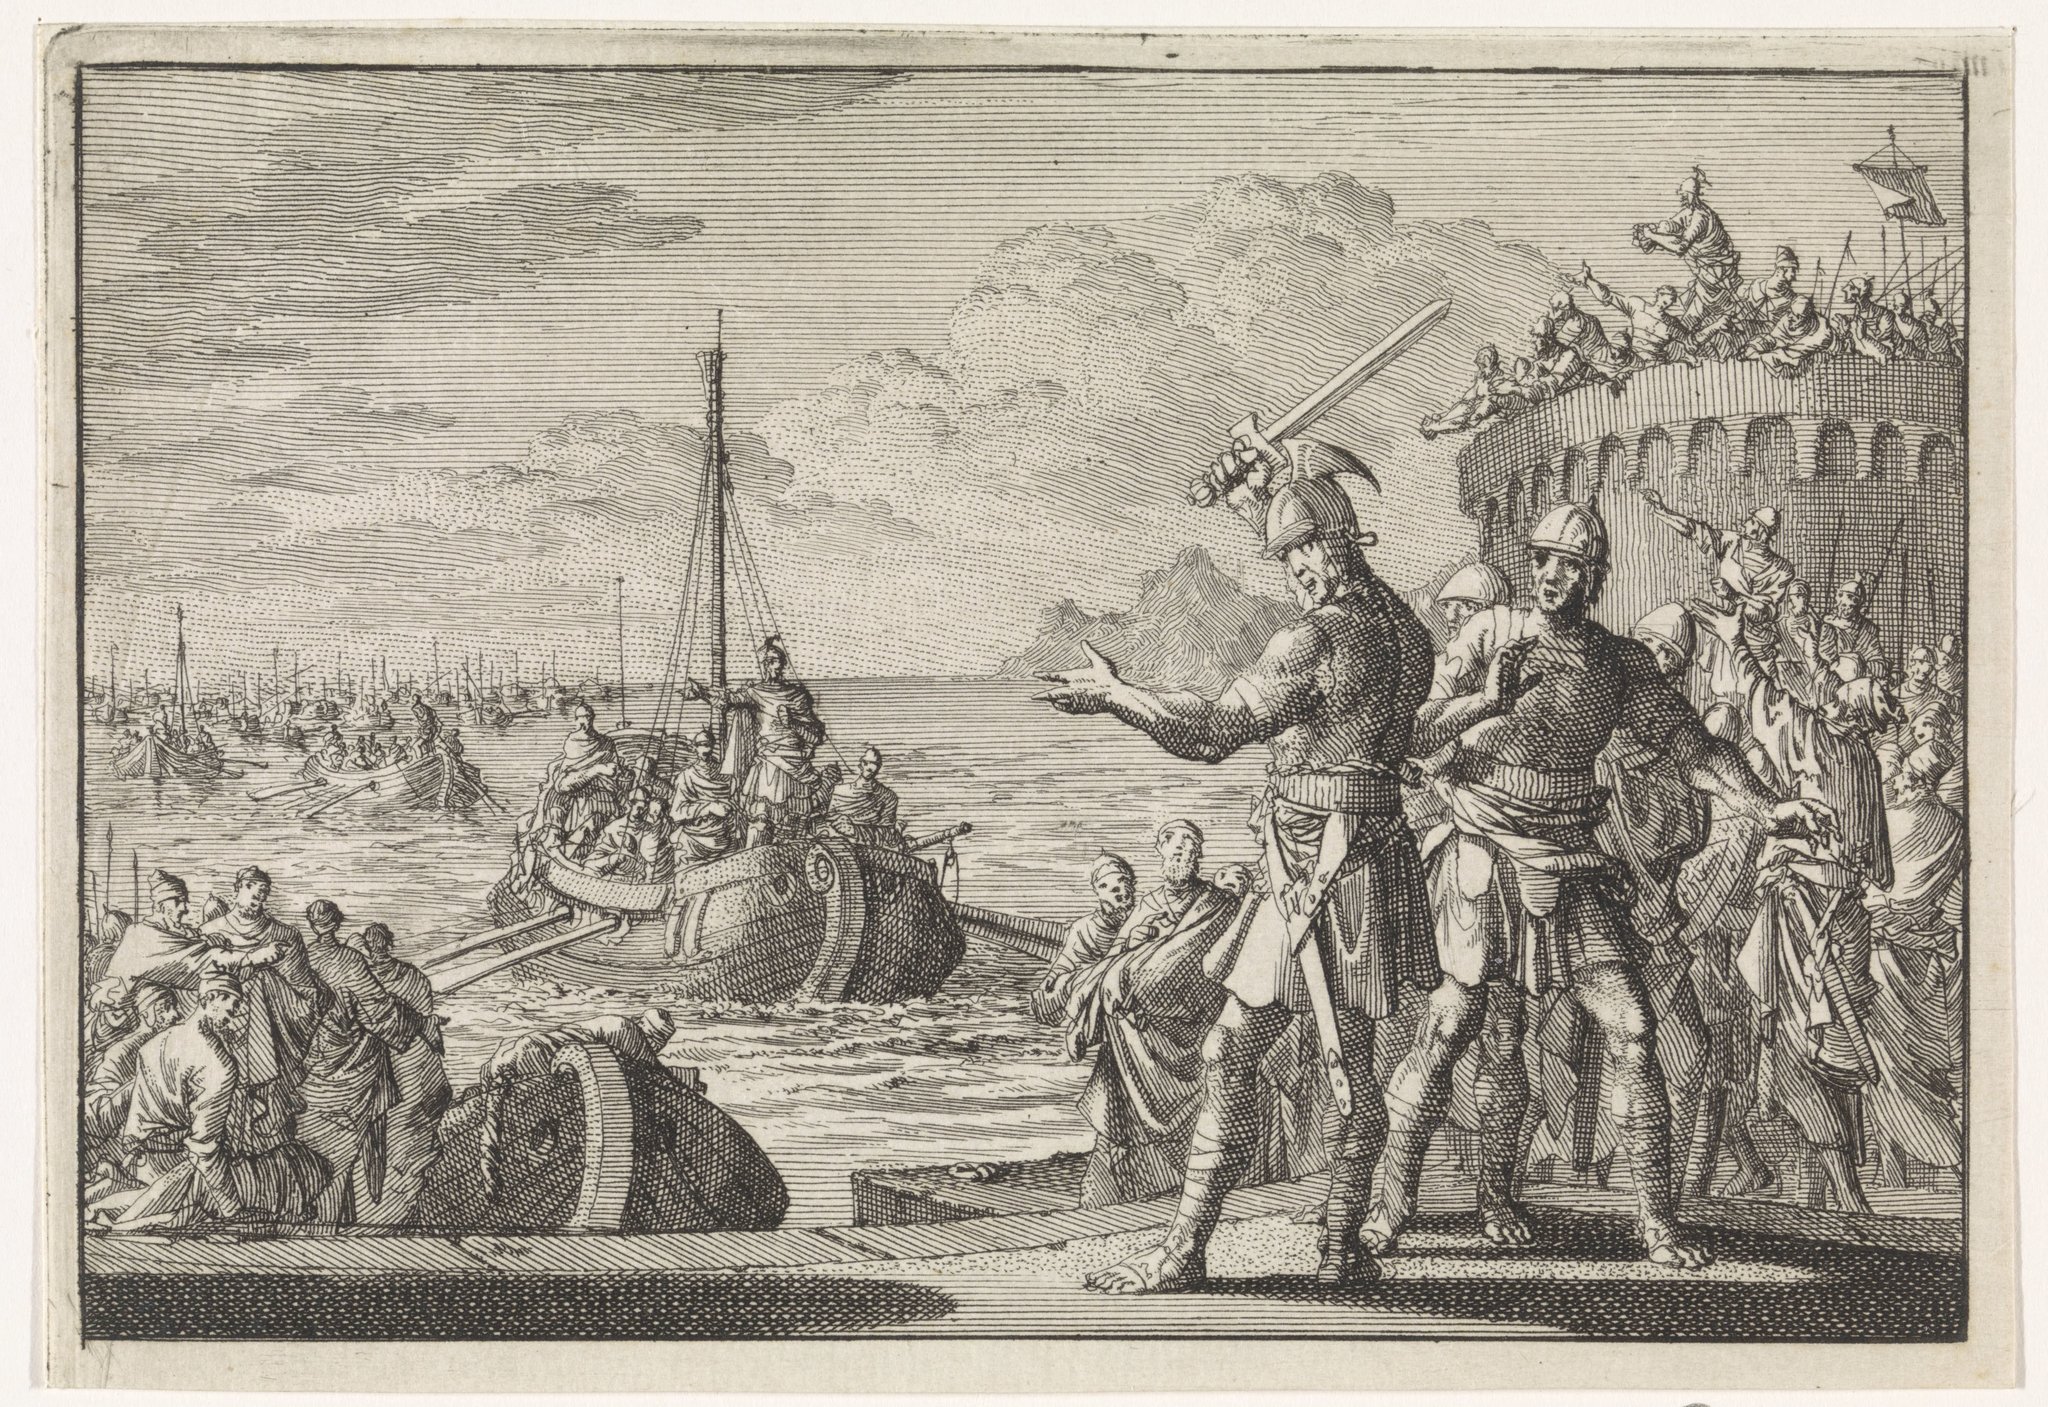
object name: print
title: Josephus beveelt Klitus zijn linkerhand af te houwen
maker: jan luyken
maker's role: draughtsman, print maker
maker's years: 1649-1712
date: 1704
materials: paper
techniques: etching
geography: amsterdam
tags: corporal punishment in public, violent death by removal of parts of the body by cutting, sawing, tearing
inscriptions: collector's mark: Lugt 2228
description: Prent ook gebruikt als boekillustratie in: Josephus, Flavius. Alle de Werken, 2 delen. Amsterdam: Pieter Mortier, 1704, dl. 2, p. 596.